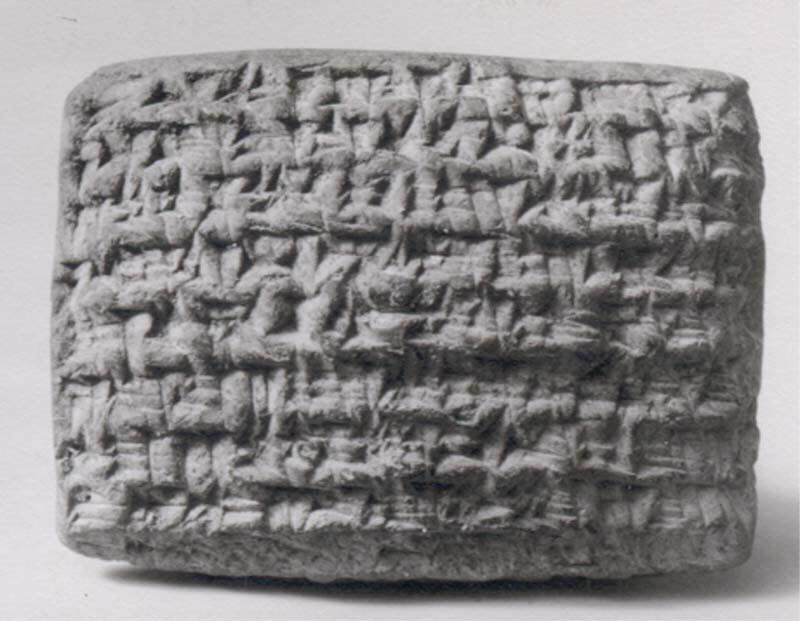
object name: cuneiform tablet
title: Cuneiform tablet: assignment of note, archive of Iddin-Nabu and Shellebi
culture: achaemenid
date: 495 BCE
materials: clay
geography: mesopotamia